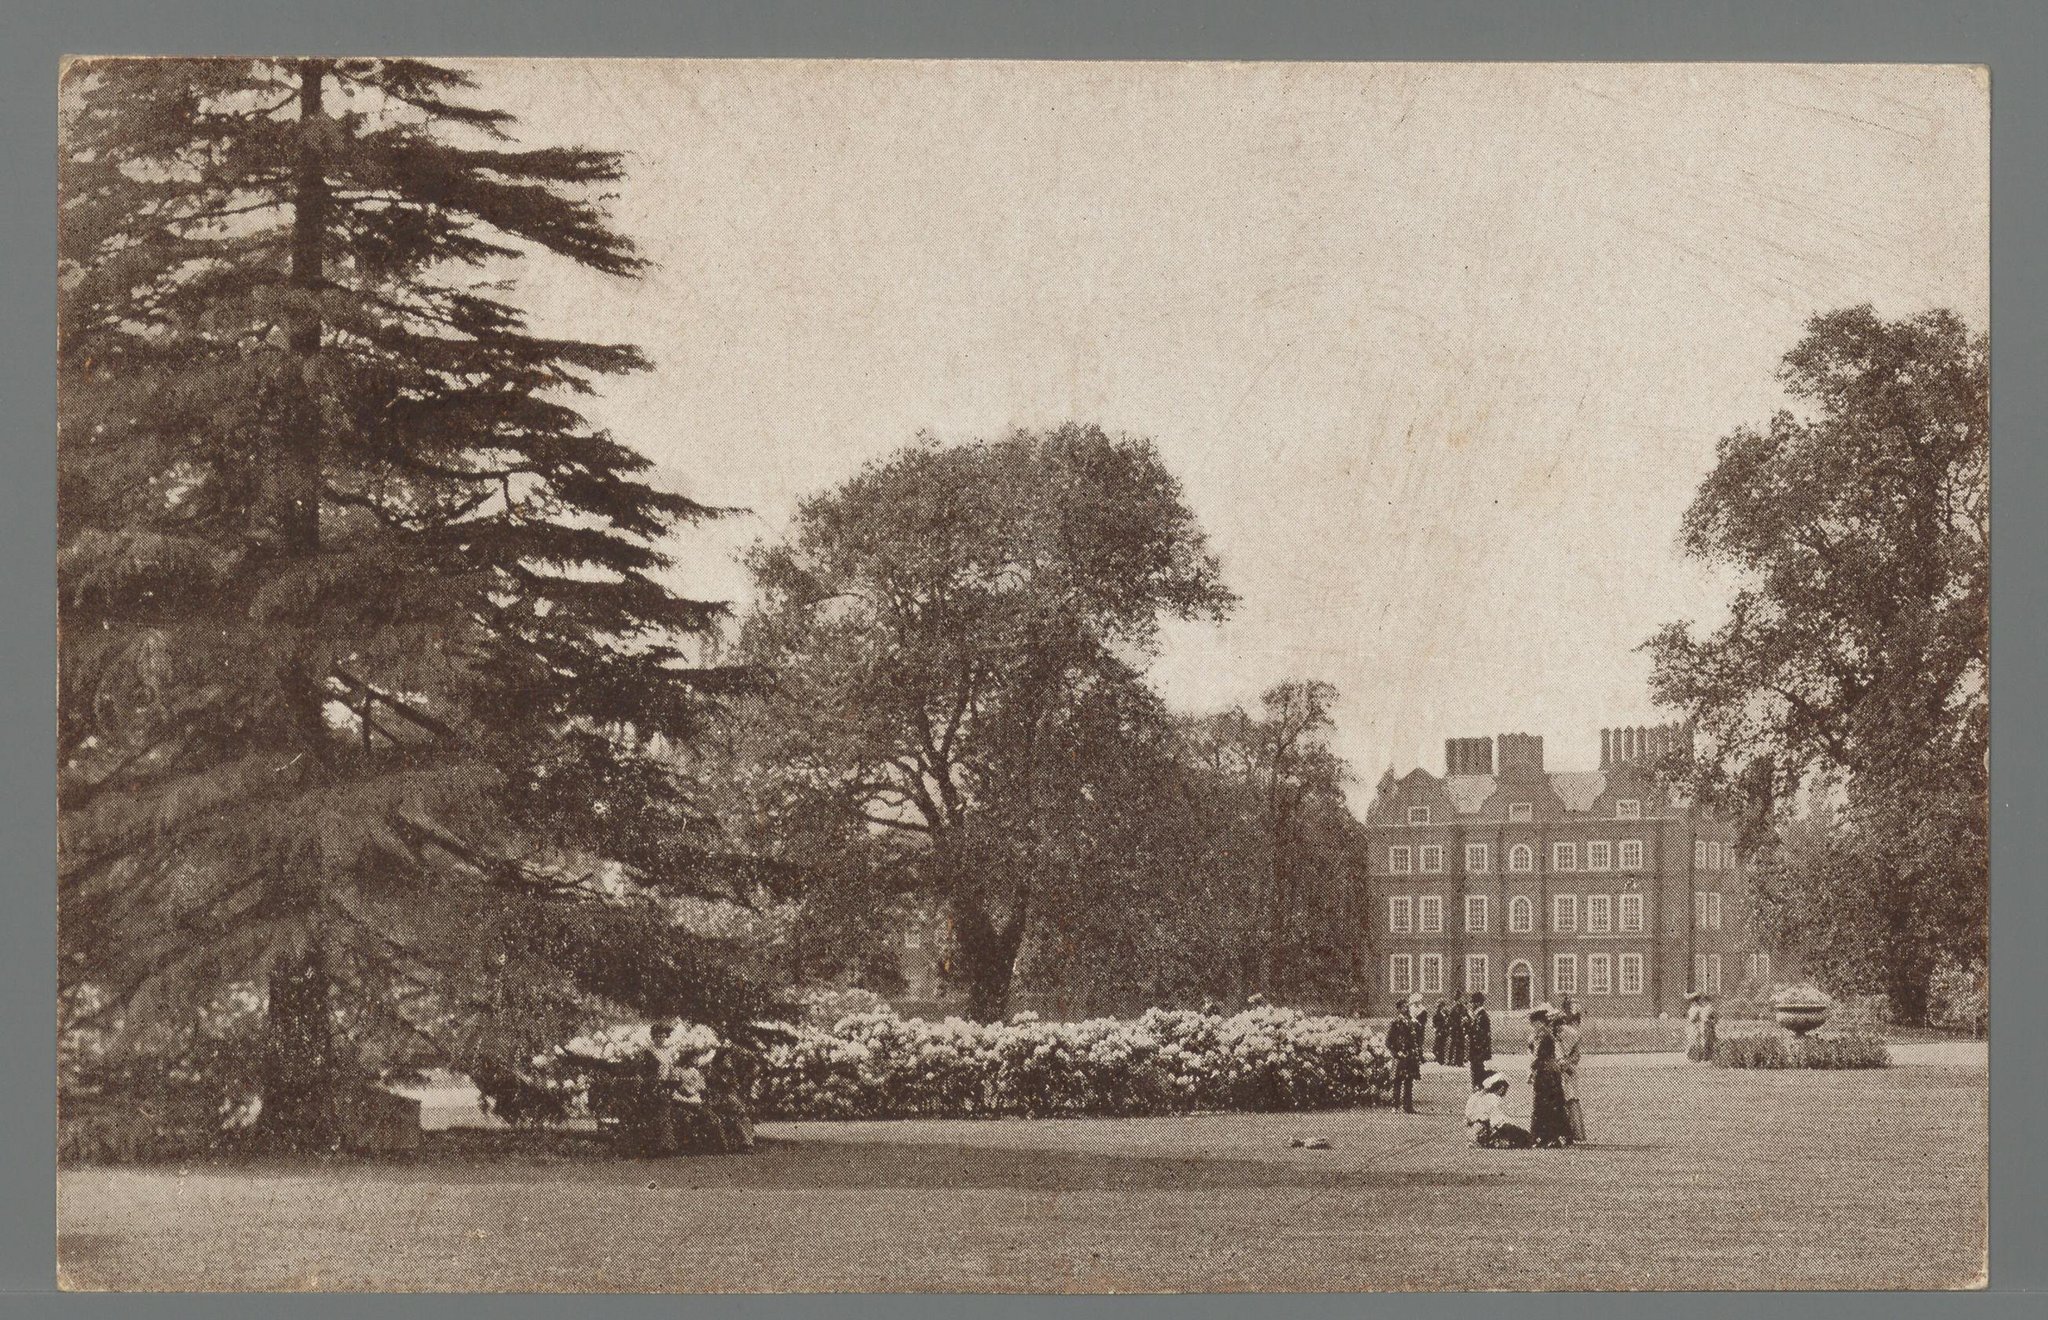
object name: photomechanical print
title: The G&P Series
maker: Anonymous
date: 1902-1930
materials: cardboard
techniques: autotype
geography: london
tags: garden, palace